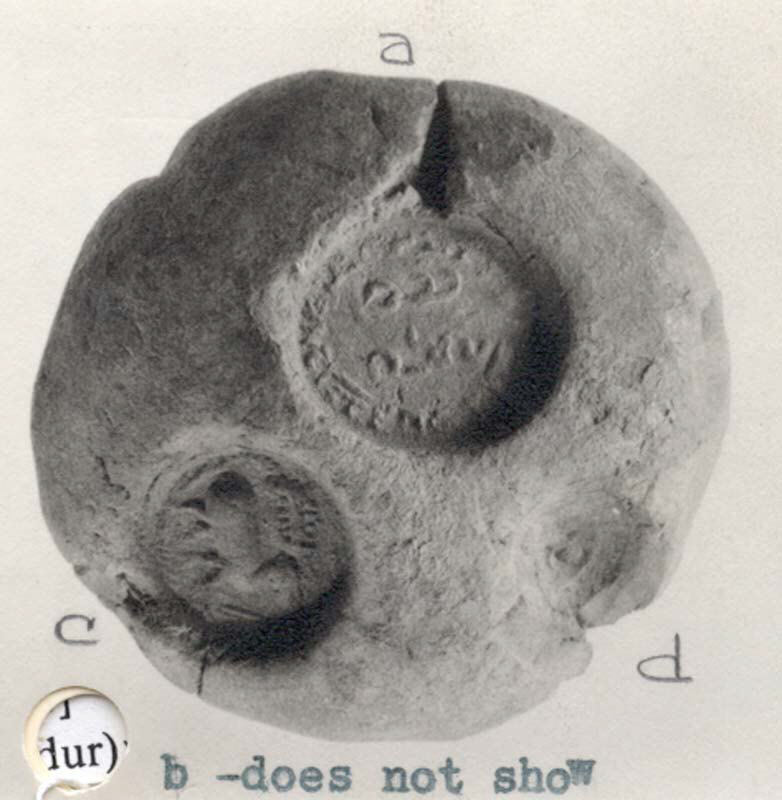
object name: sealing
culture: sasanian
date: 601-700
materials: clay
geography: iran